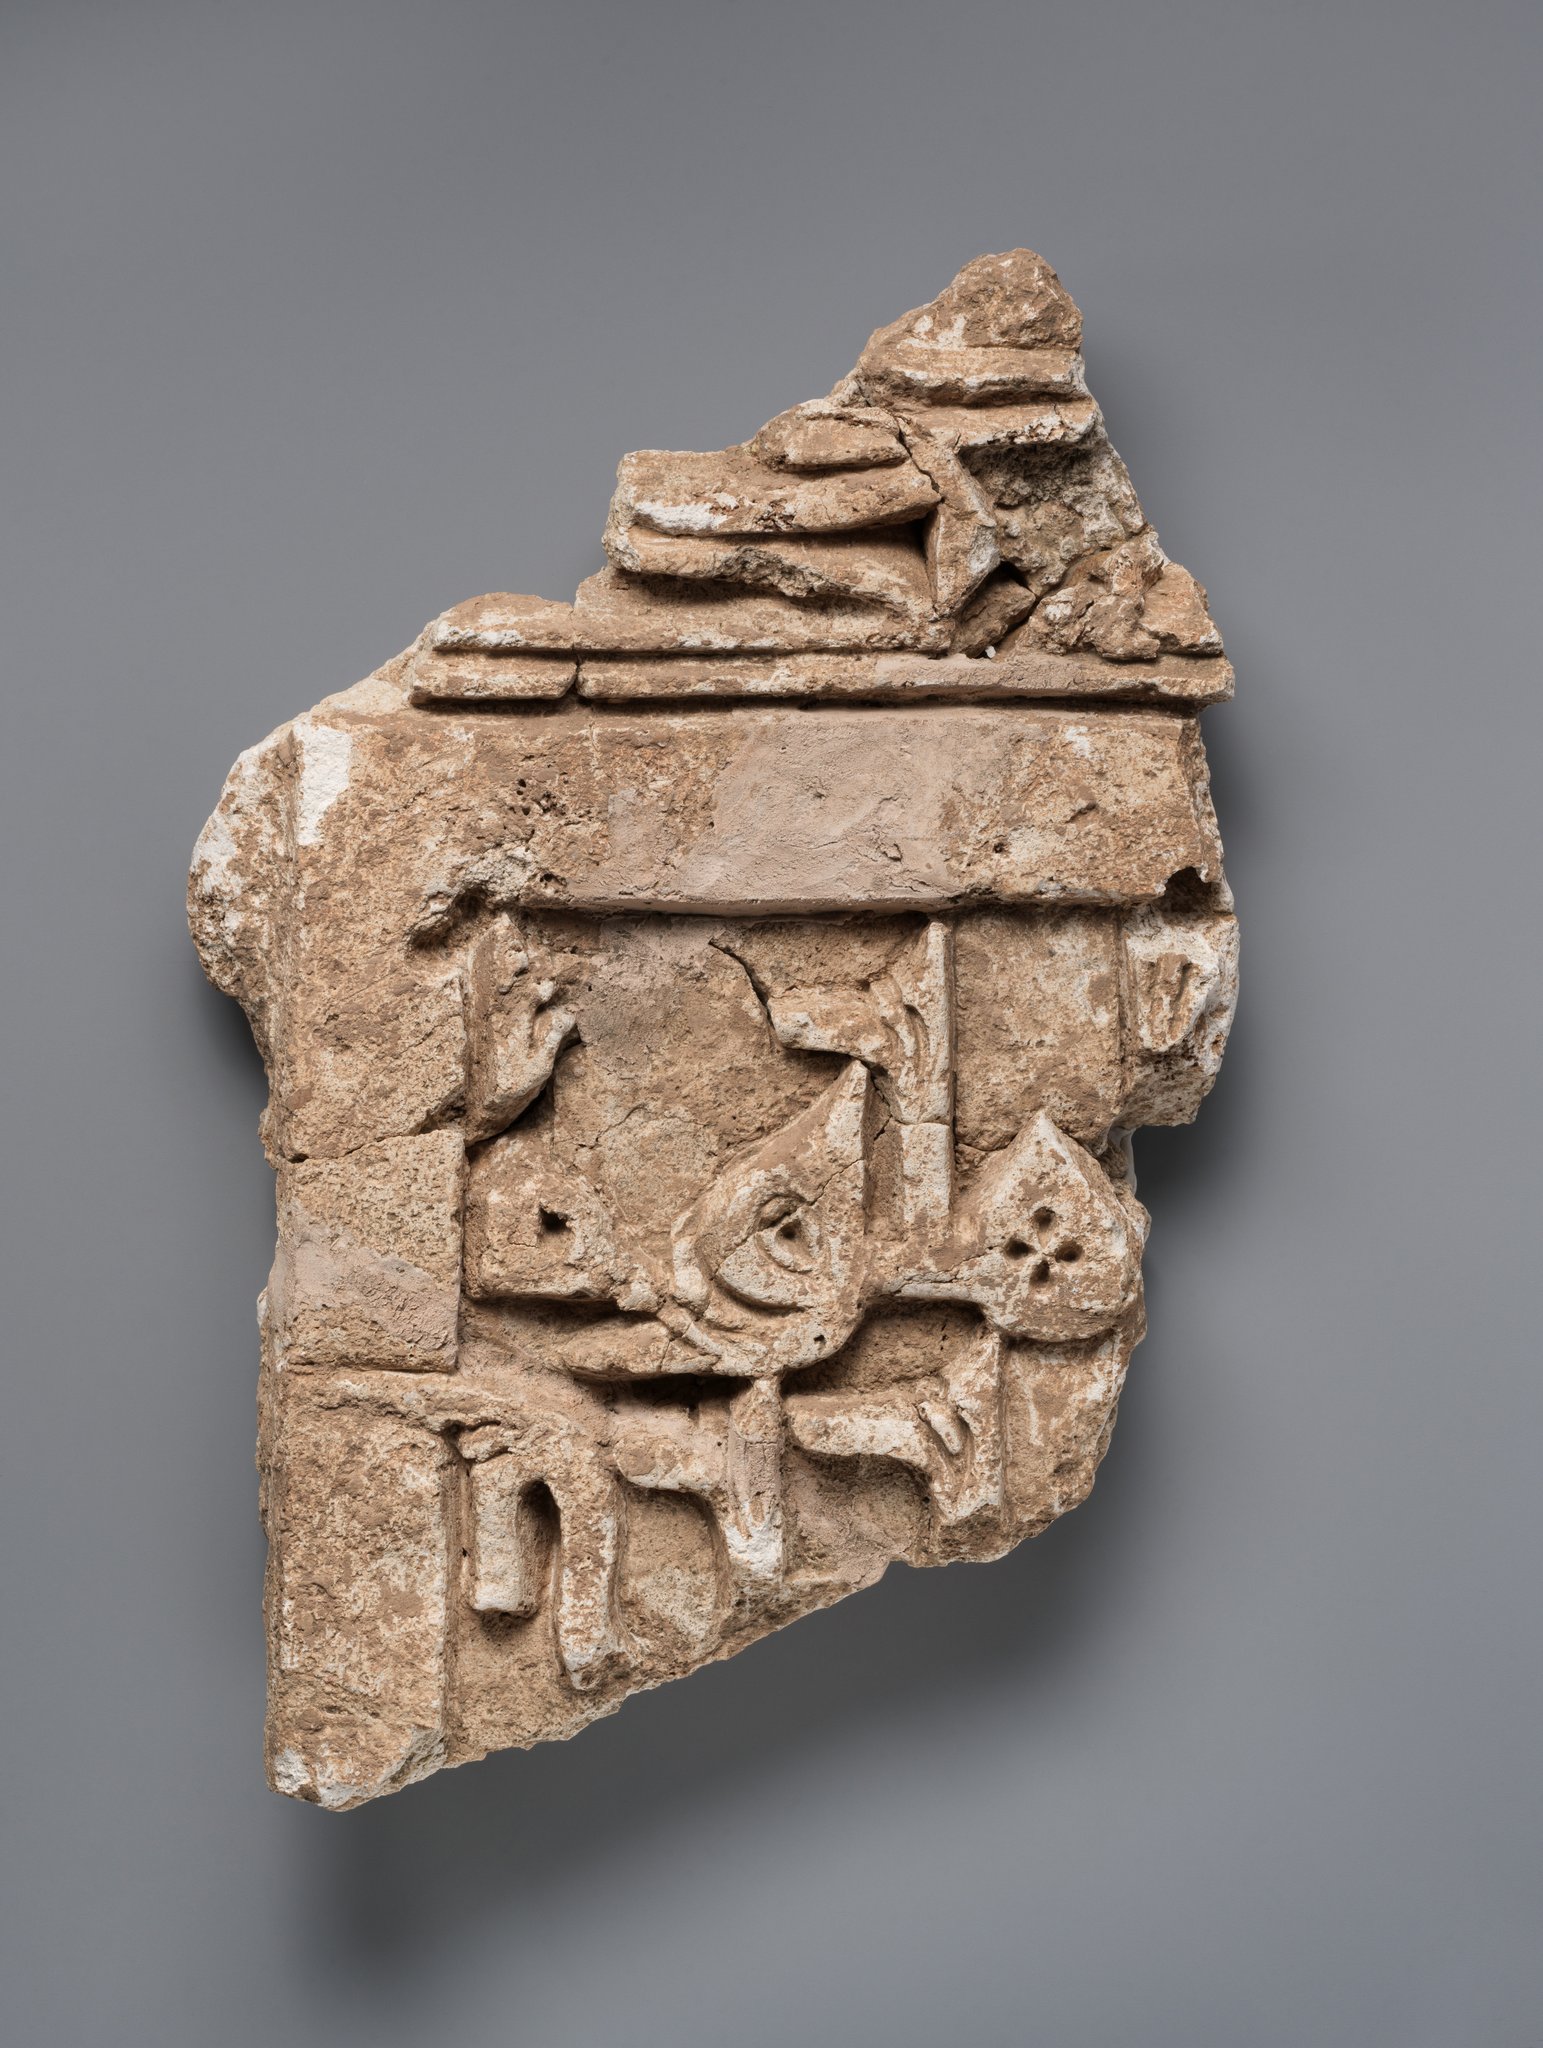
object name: fragment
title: Stucco Fragment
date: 701-1200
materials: plaster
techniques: carving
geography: iran